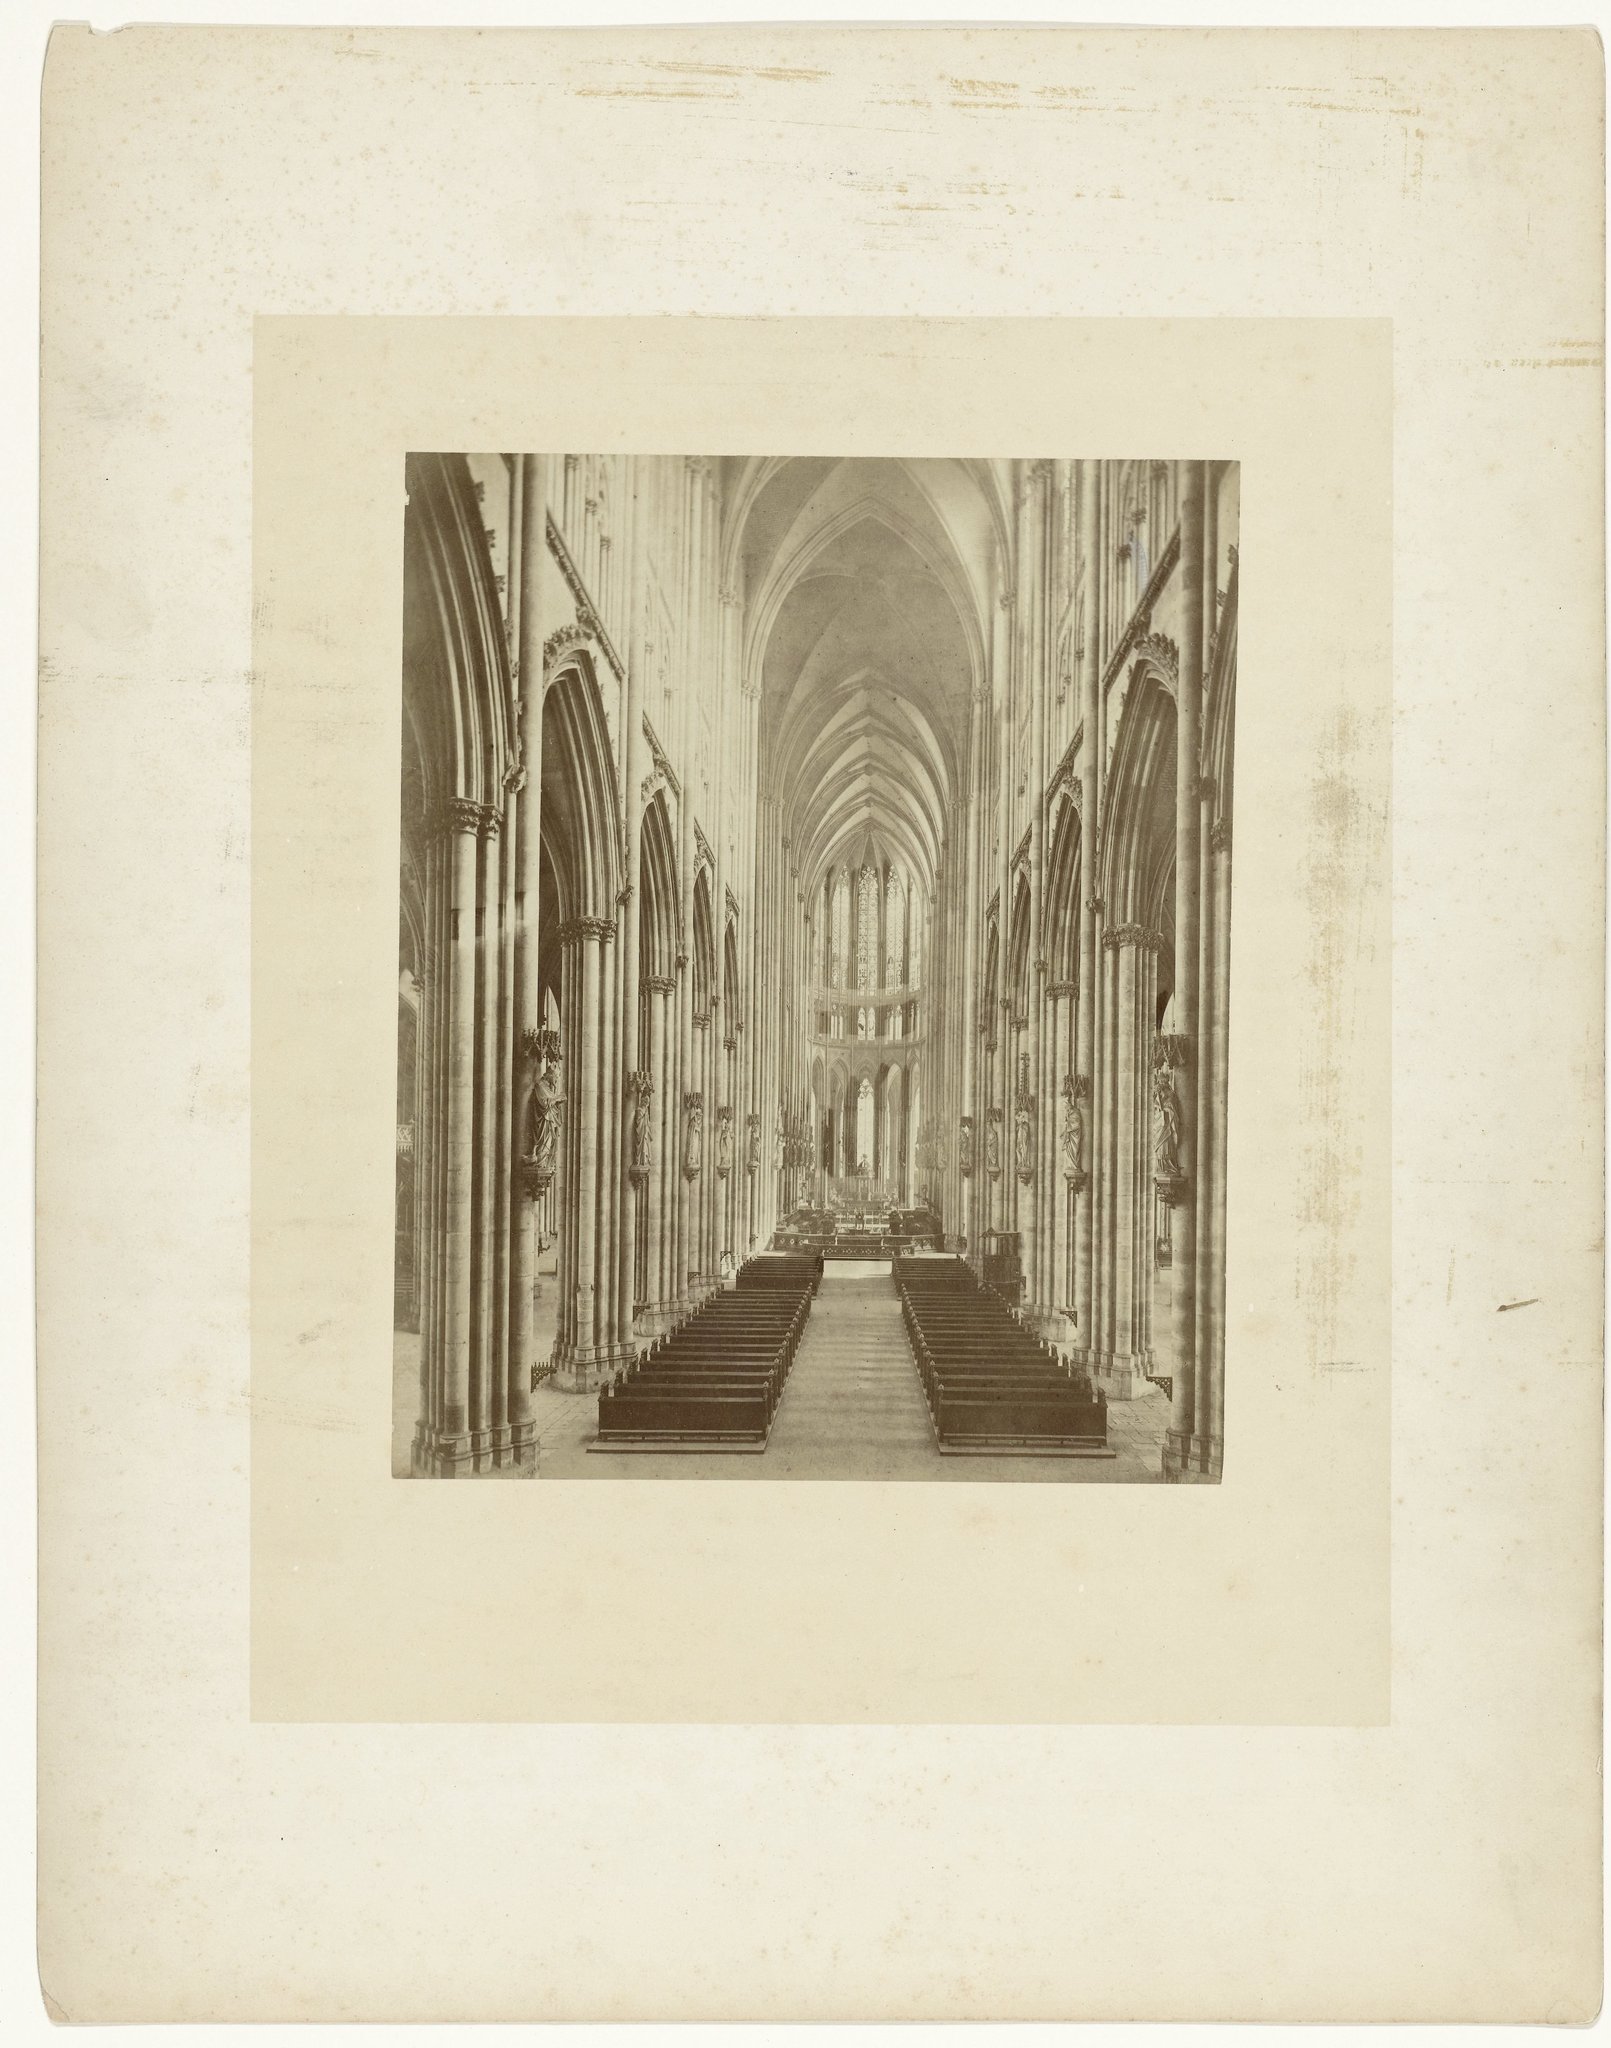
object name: photograph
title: Interieur van een Nederlandse gothische katholieke kerk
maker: Anonymous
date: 1870-1900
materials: cardboard, paper, photographic support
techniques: albumen print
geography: netherlands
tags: interior of church